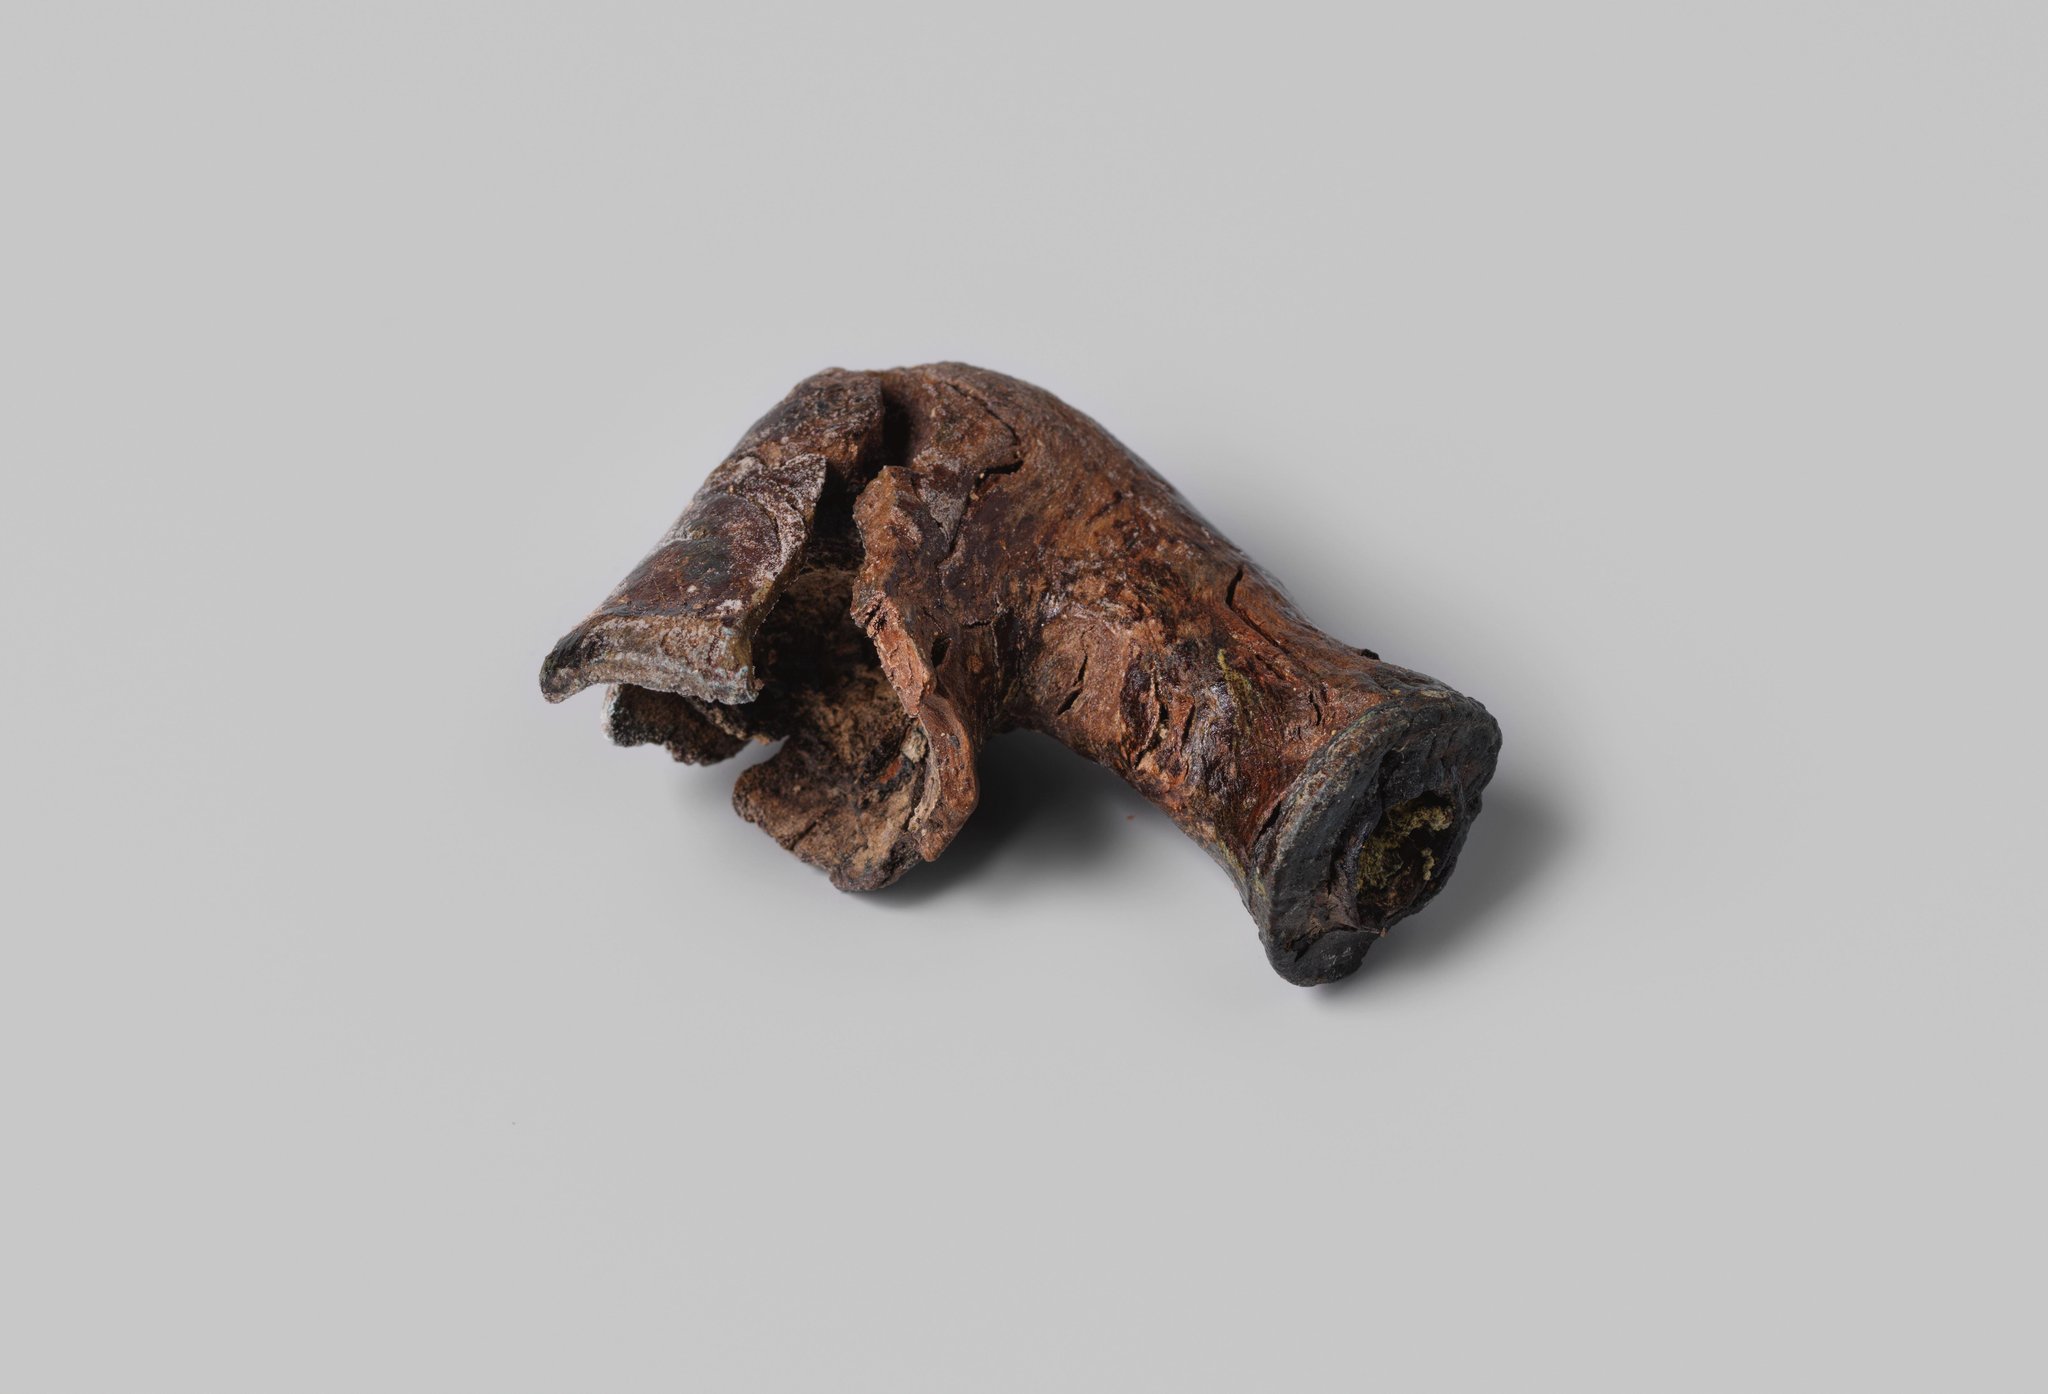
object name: pipe bowl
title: Fragment pijpenkop uit het wrak van de Oost-Indiëvaarder -Hollandia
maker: Anonymous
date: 1700-1743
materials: wood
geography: netherlands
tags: verenigde oostindische compagnie, hollandia (schip), annet